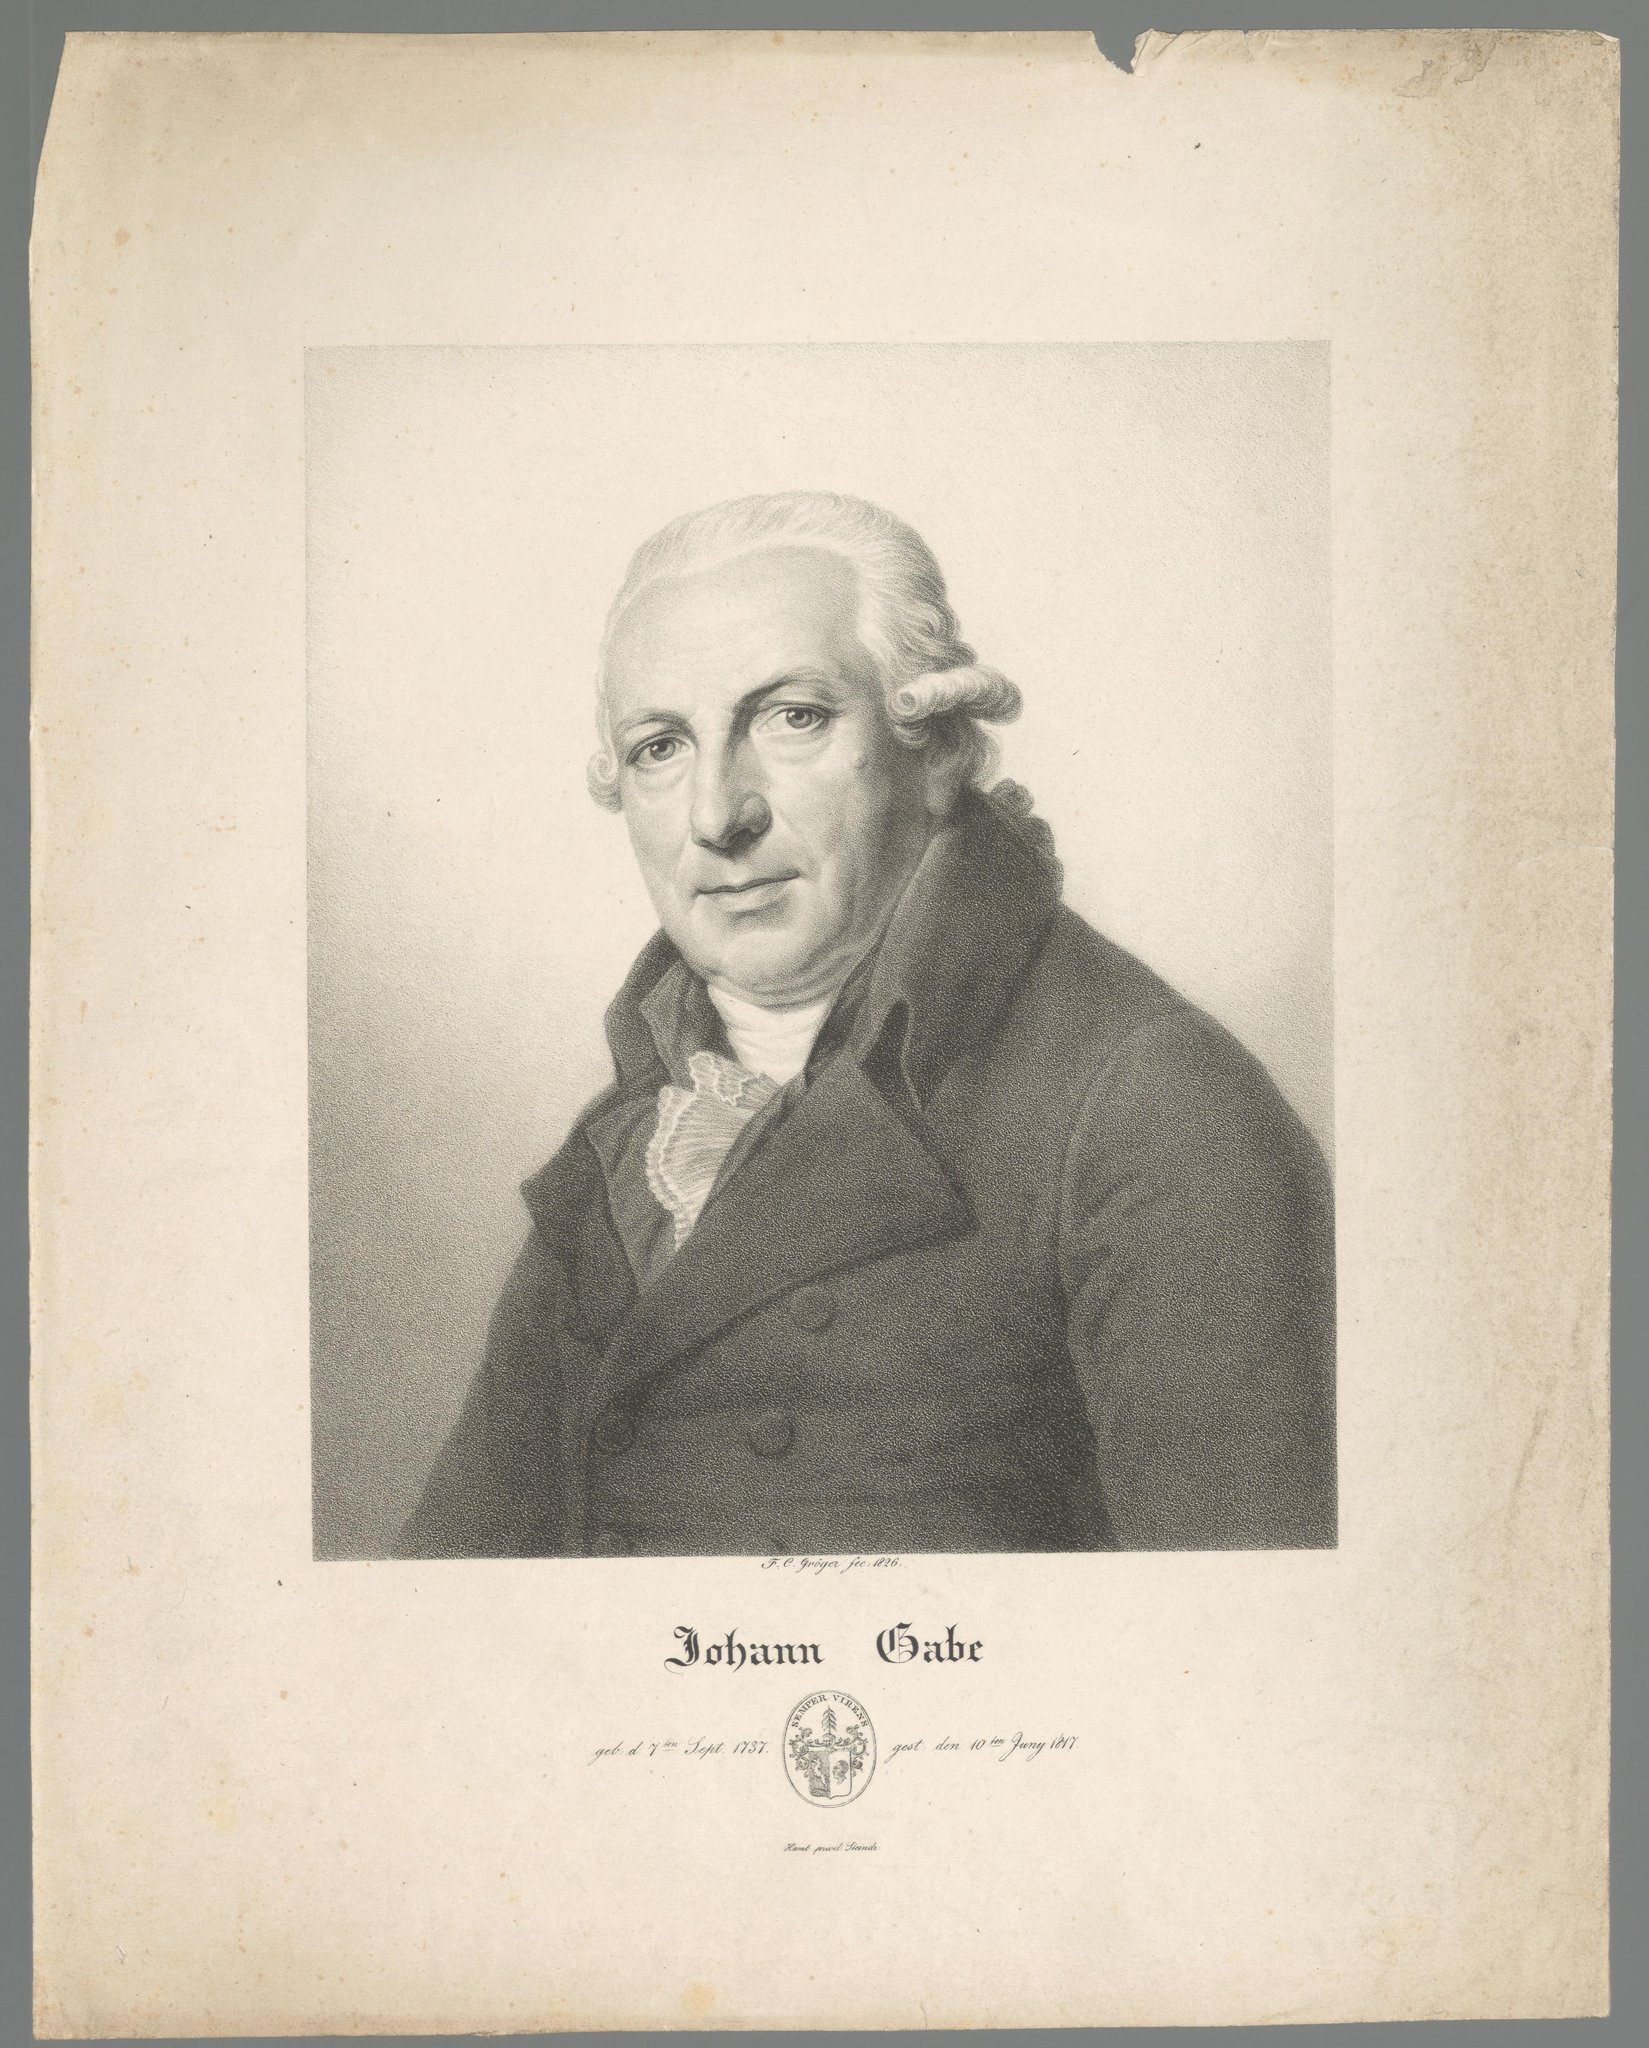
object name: print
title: Portret van Johann Gabe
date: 1826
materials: paper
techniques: lithograph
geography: hamburg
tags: adult man, historical persons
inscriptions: collector's mark: Lugt 2228